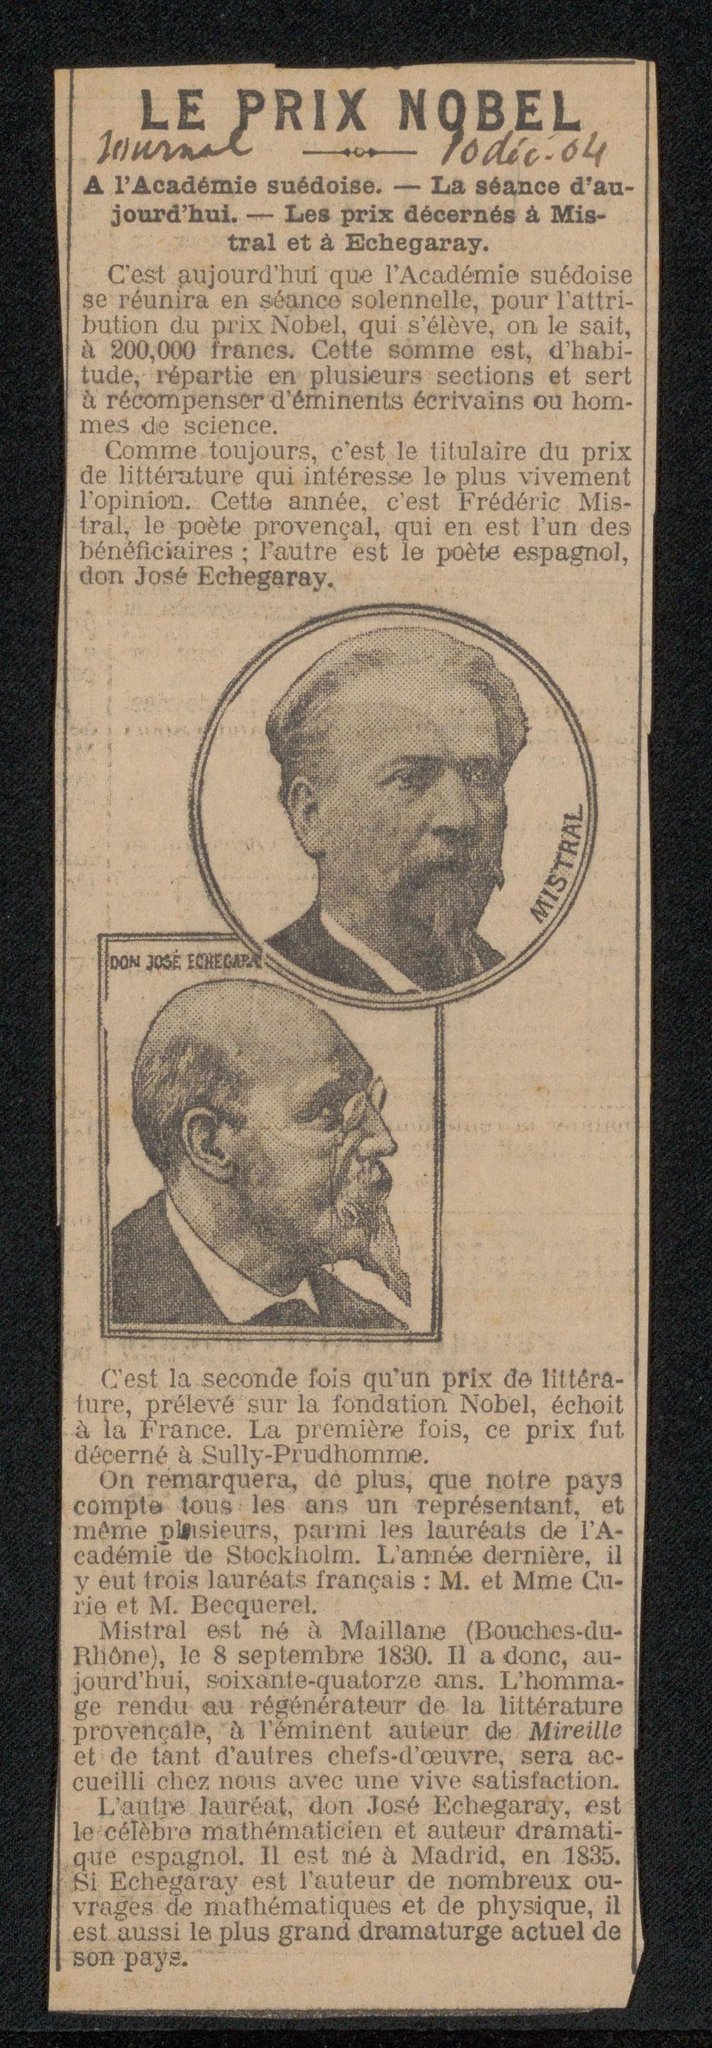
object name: newspaper clipping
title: Krantenknipsel uit archief Philip Zilcken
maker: Anonymous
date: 1904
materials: ink, paper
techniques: pen, printing, writing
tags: frédéric mistral, the hague, painter, draughtsman, philip zilcken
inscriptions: collector's mark: ‘RPK’